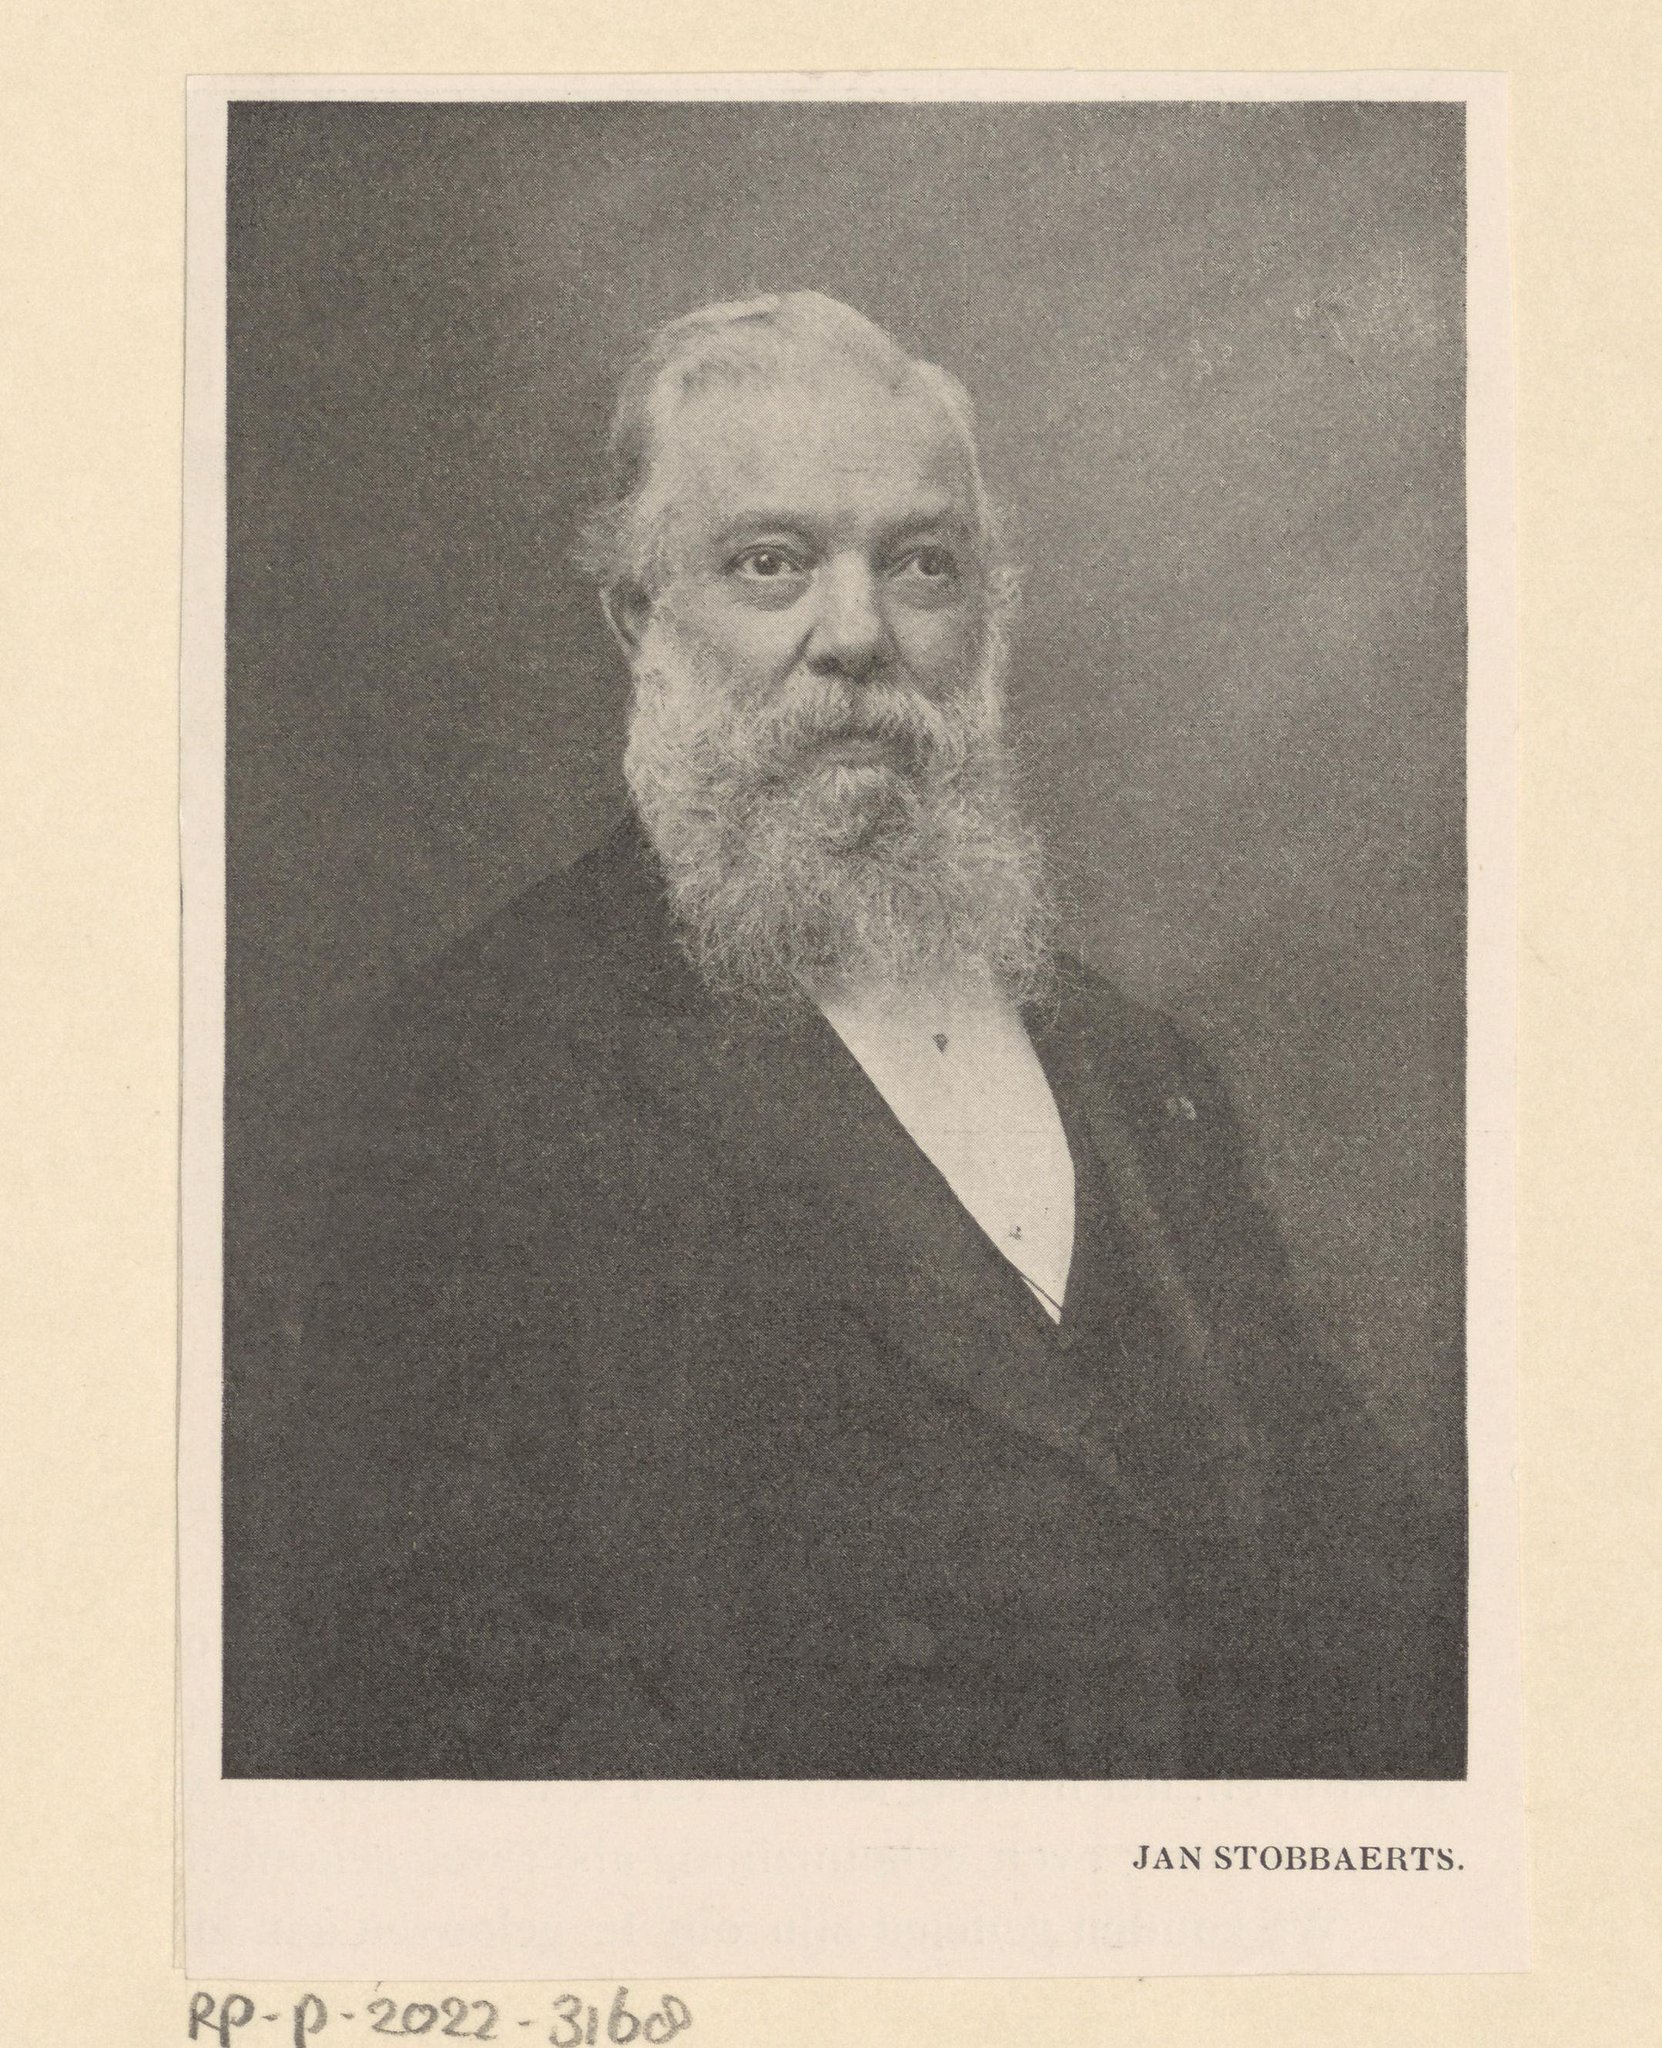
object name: photomechanical print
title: Portret van Jan Stobbaerts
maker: Anonymous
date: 1888-1970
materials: paper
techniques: letterpress printing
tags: antwerp, print maker, draughtsman, jan stobbaerts, historical persons, portrait, self-portrait of artist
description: Fotomechanische afdruk uit een onbekende publicatie.